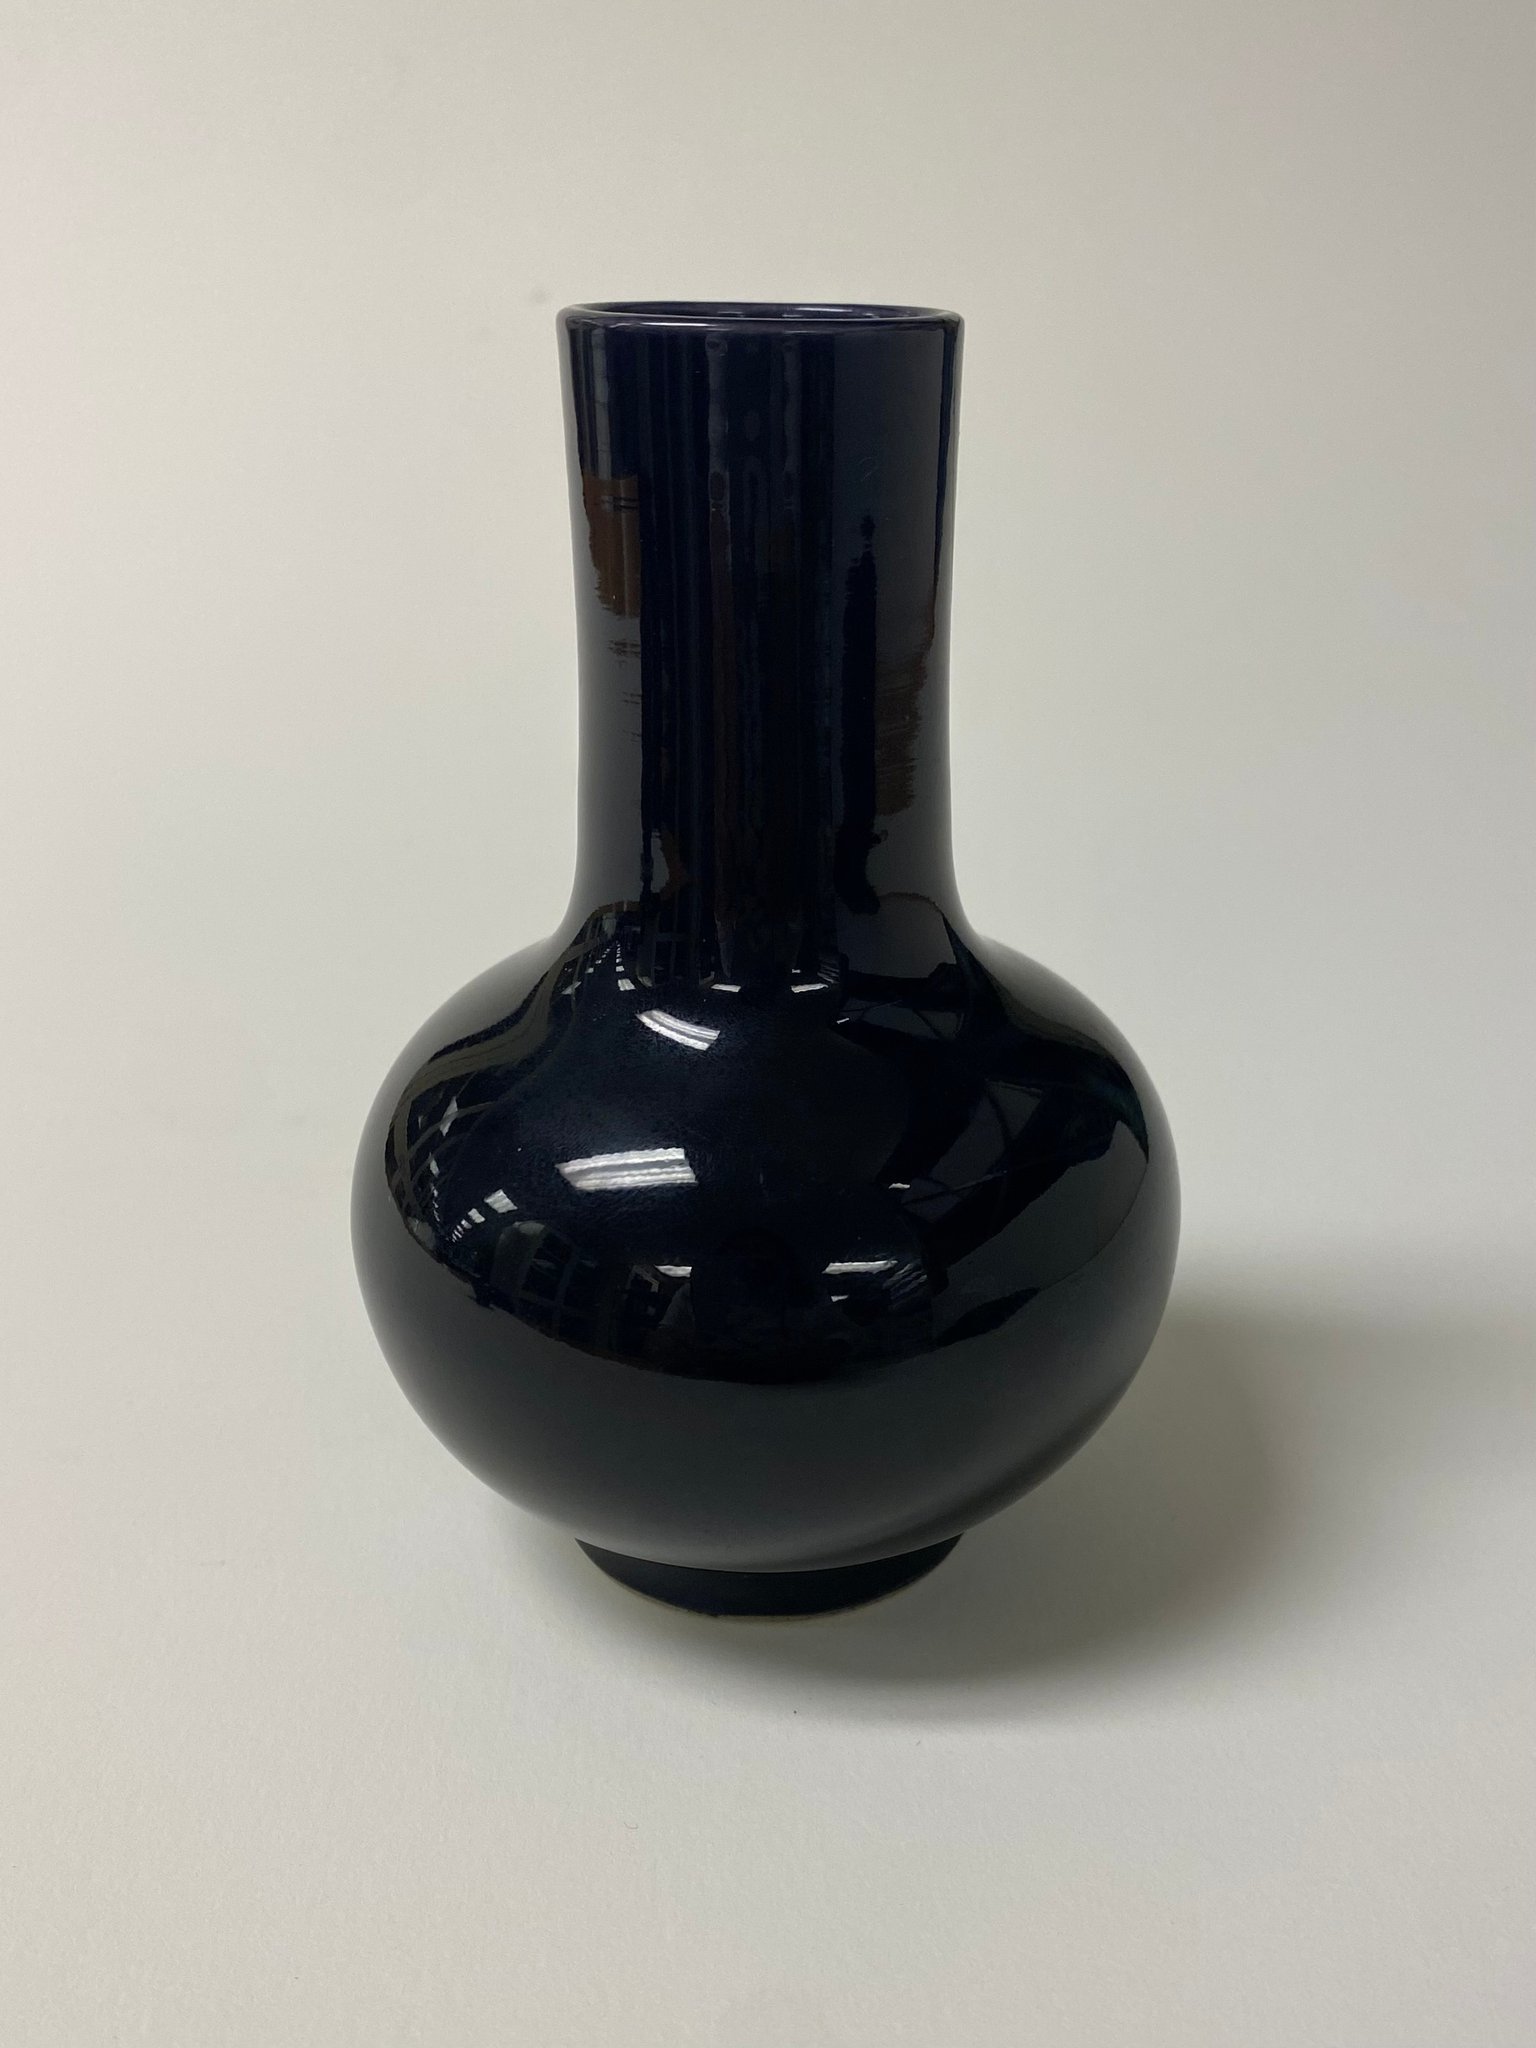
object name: bottle vase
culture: chinese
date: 1701-1800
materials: glaze, porcelain